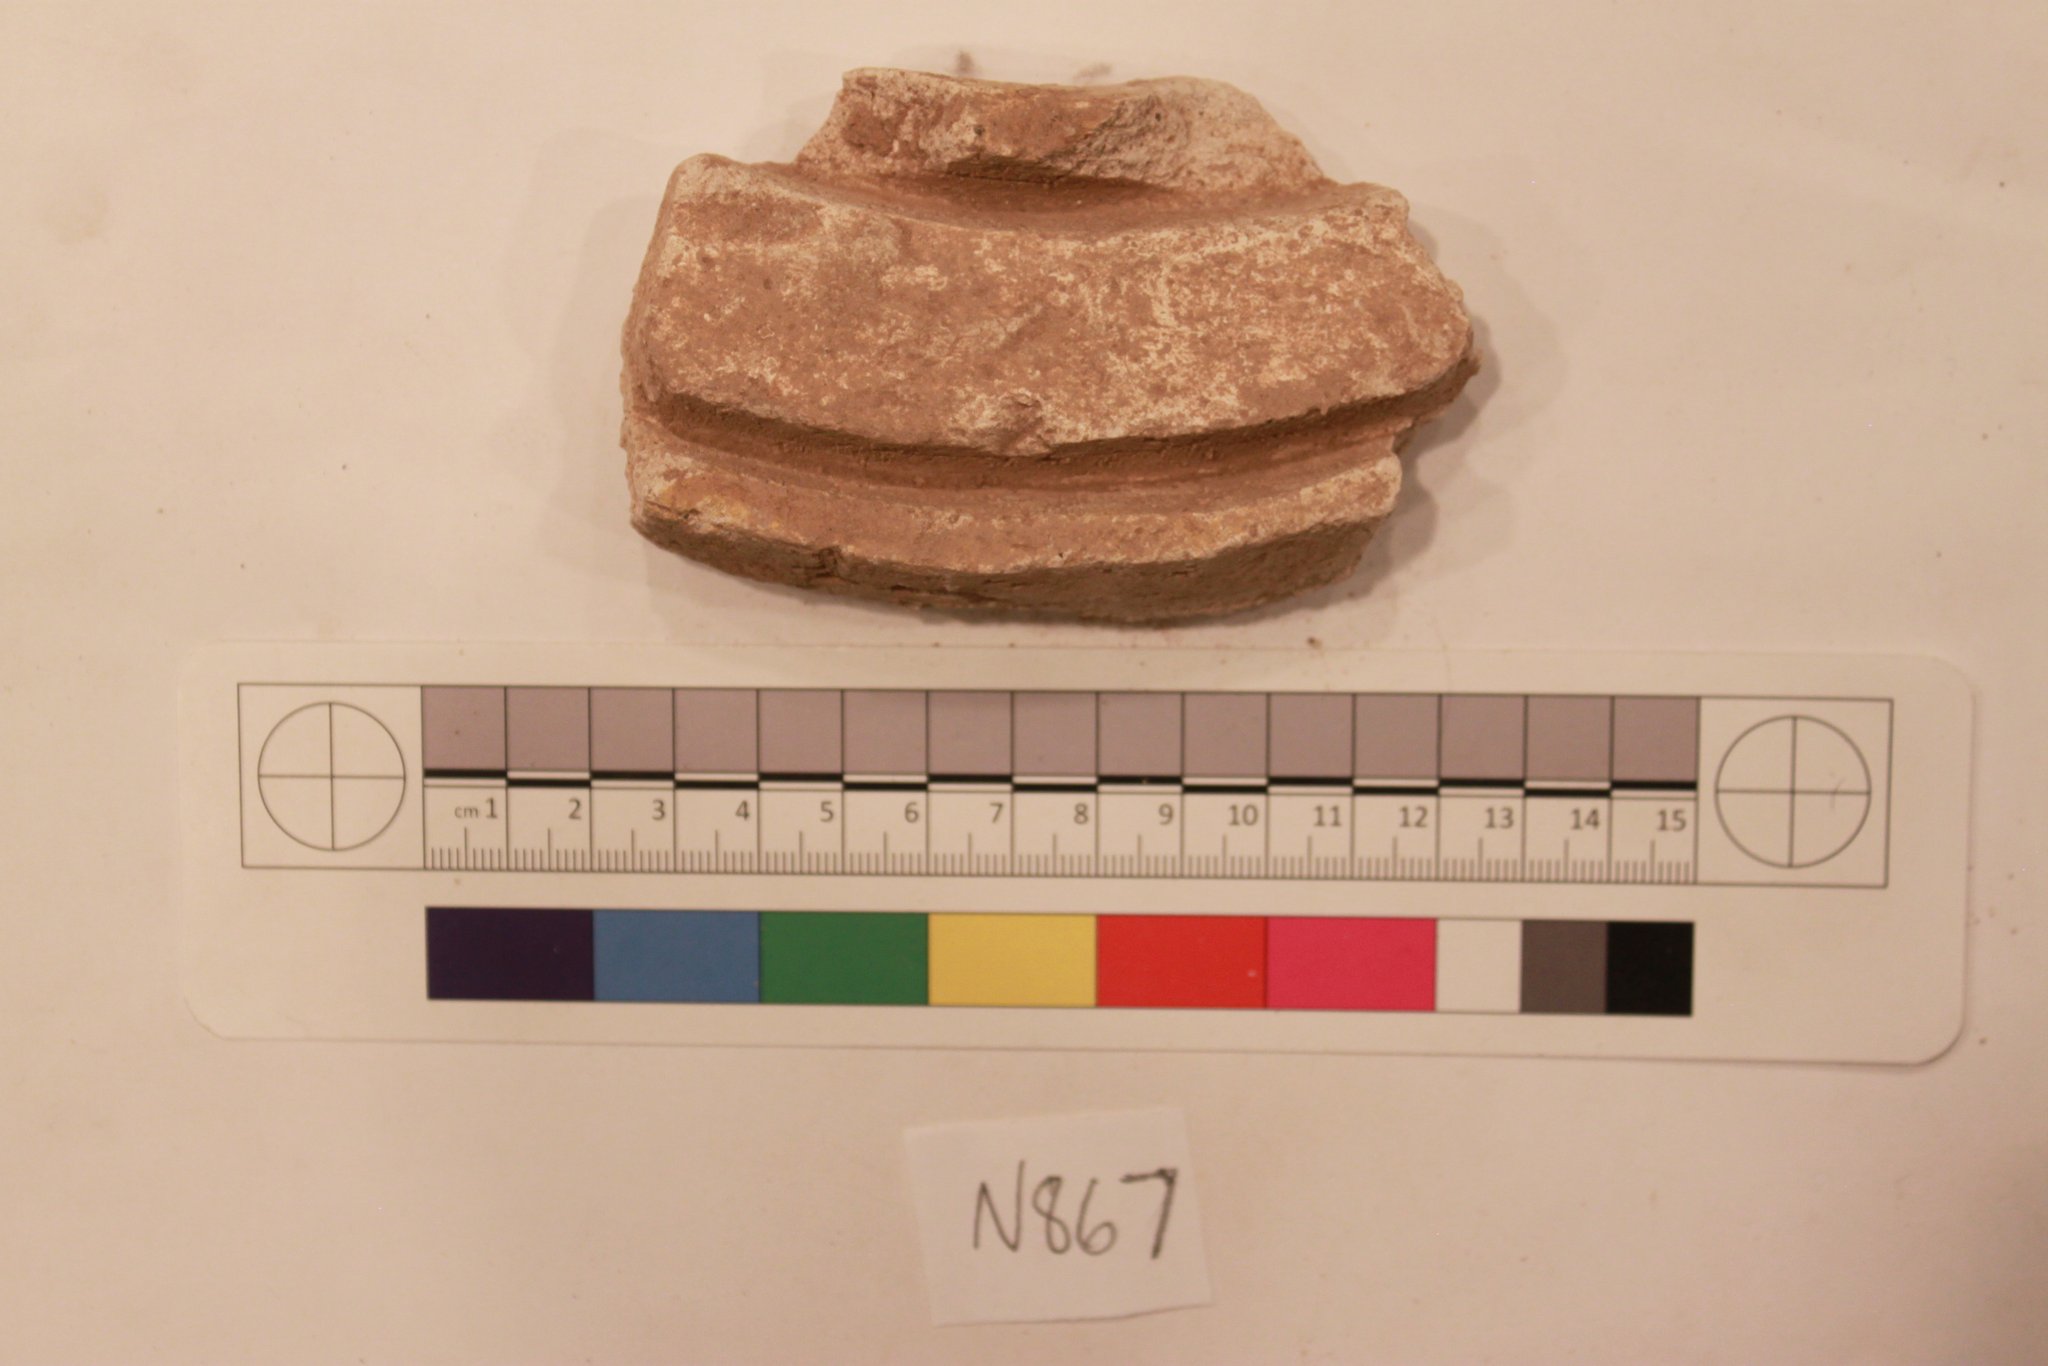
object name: fragment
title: Stucco Fragment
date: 701-1200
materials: plaster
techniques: carving, painting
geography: iran